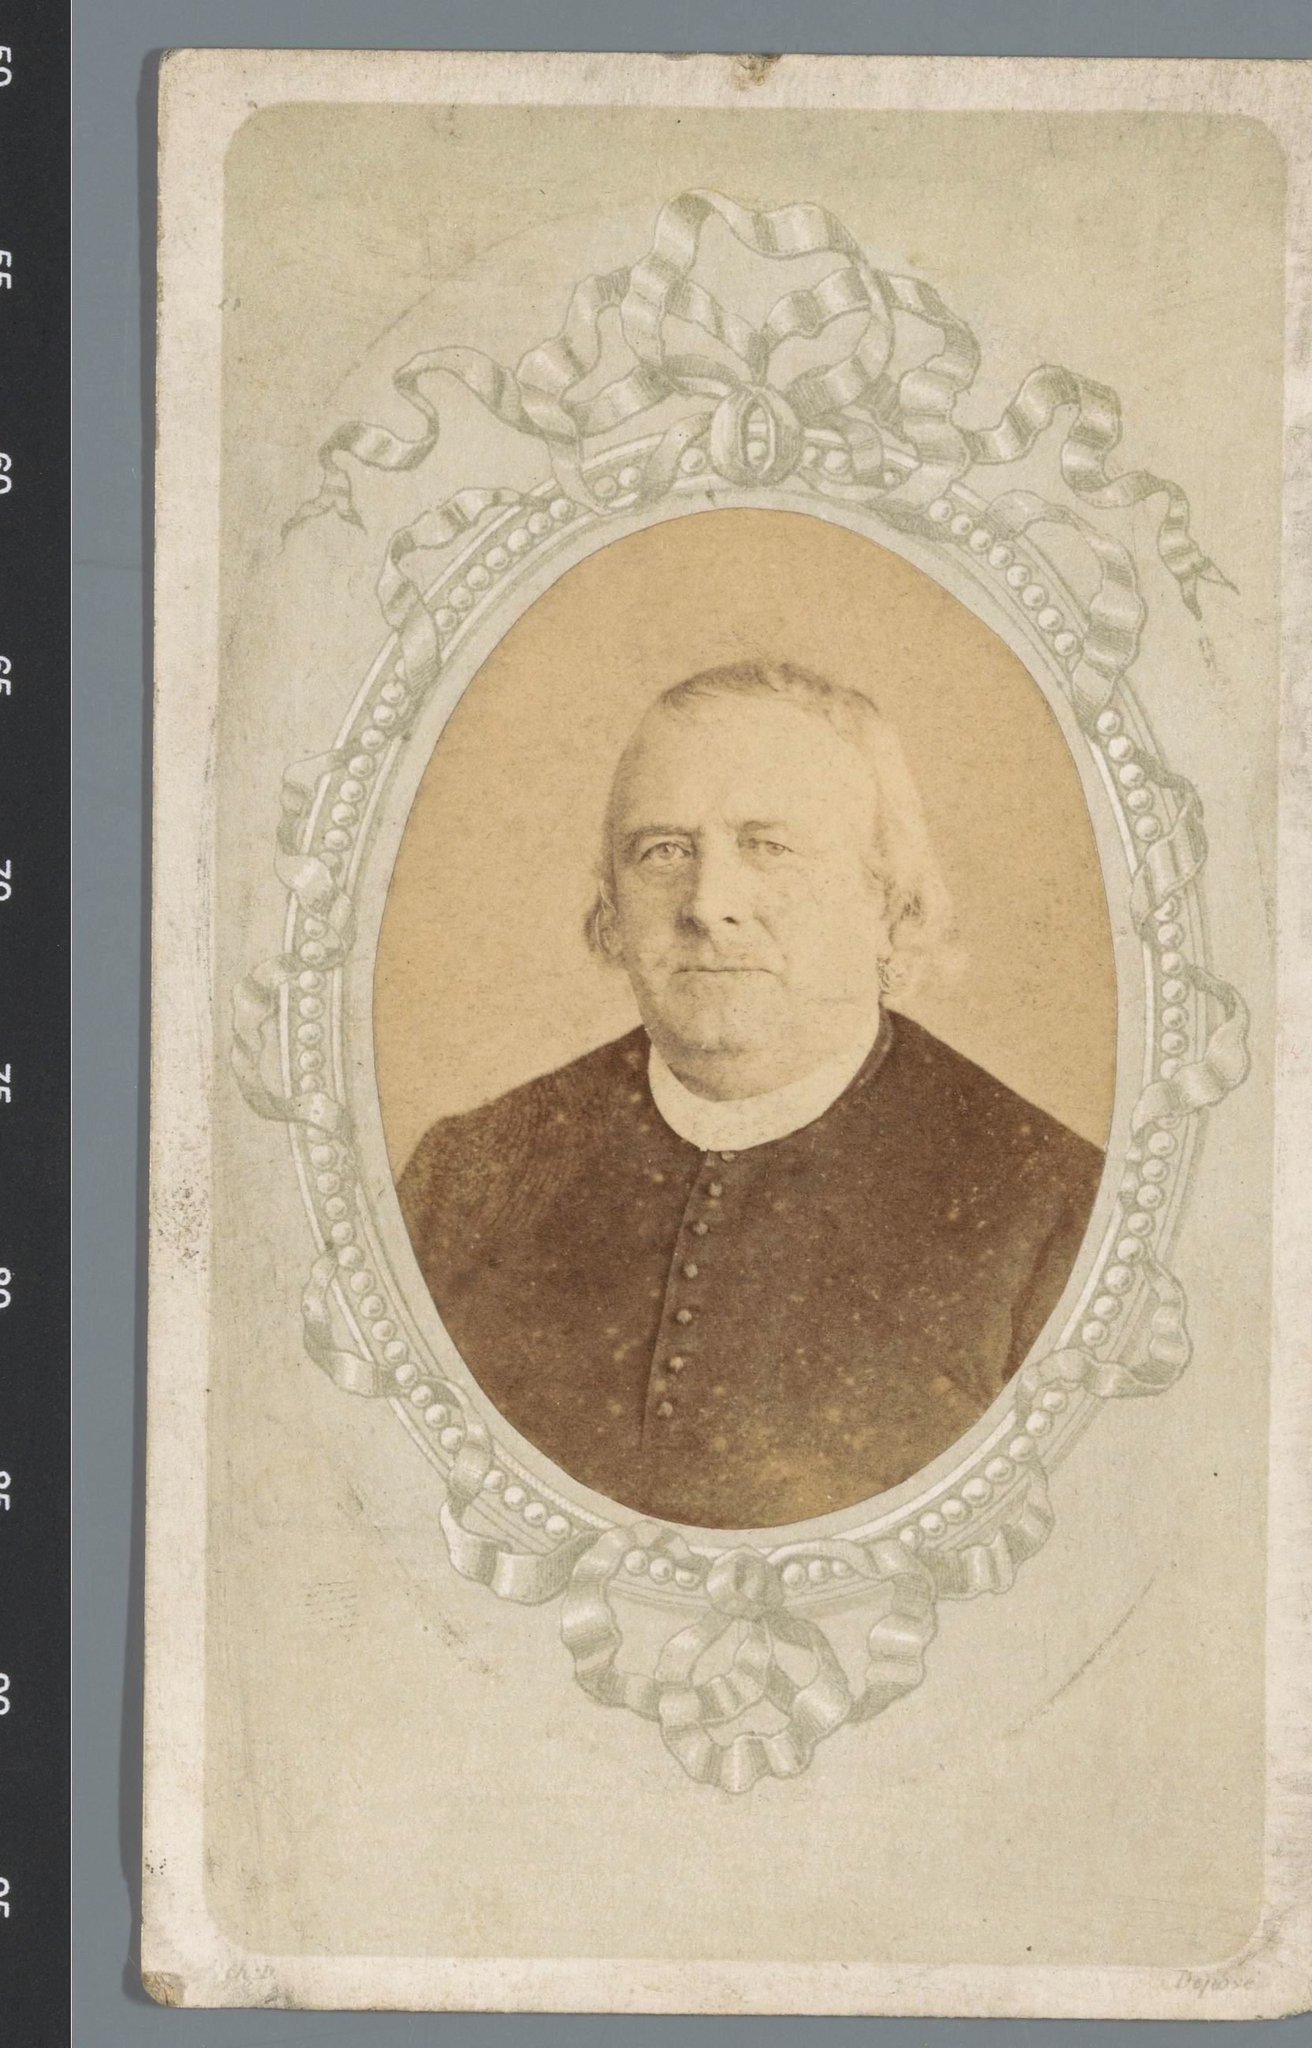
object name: carte de visite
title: Portret van een onbekende man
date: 1856-1876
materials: cardboard, paper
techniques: albumen print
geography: leuven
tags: historical persons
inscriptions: inscription: ‘PHOTOGRAPHIE/ de/ CHs VERBEKE-SCHODTS,/ rue de Bruxelles 20/ LOUVAIN.’